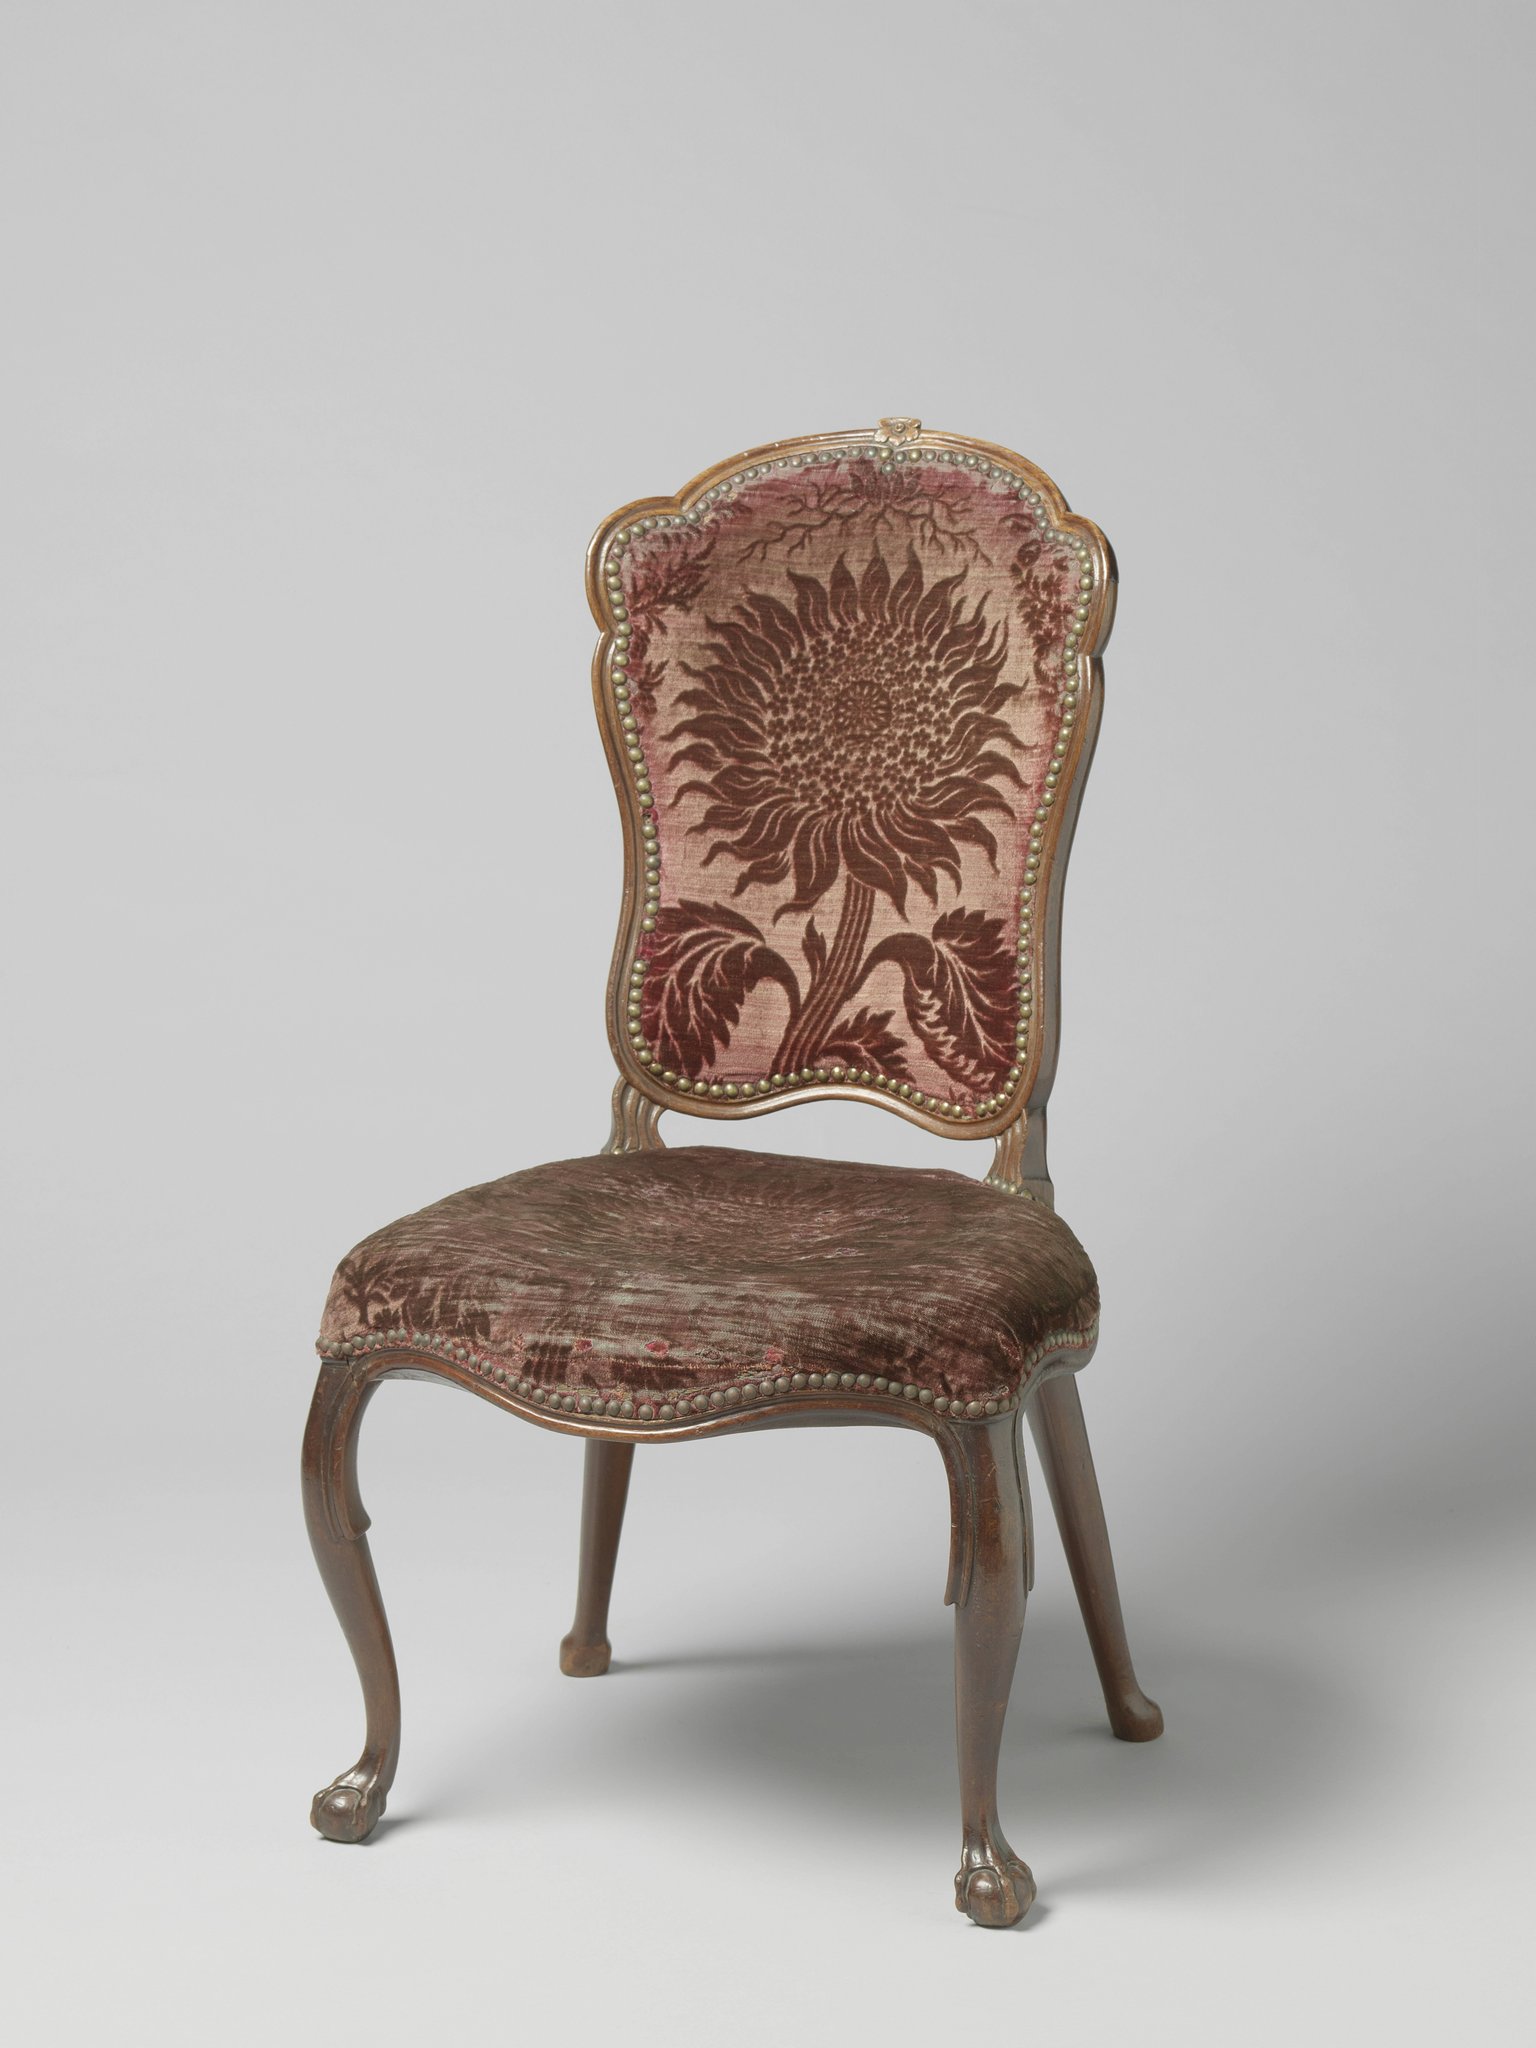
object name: seating furniture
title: Stoel, mahoniehout, bekleed met velours d'Utrecht, waarop een geperst zonnebloemmotief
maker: Anonymous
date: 1760-1775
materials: wood, wool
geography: netherlands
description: Stoel bekleed met velours d'Utrecht, waarop een geperst groot zonnebloemmotief. De S-vormige voorpoten eindigen in een vogelklauw met bal en zijn tot over de welfing extra geprofileerd. De achterpoten wijken in gespreide stand naar achteren. De zitregels en de rugregels- en dorpels zijn gewelfd. De bovendorpel van het beklede rugraam wordt bekroond door een klein bloemmotief. De bekleding is genageld. Het hol gebogen rugraam rust op gecanneleerde gewelfde stutten.